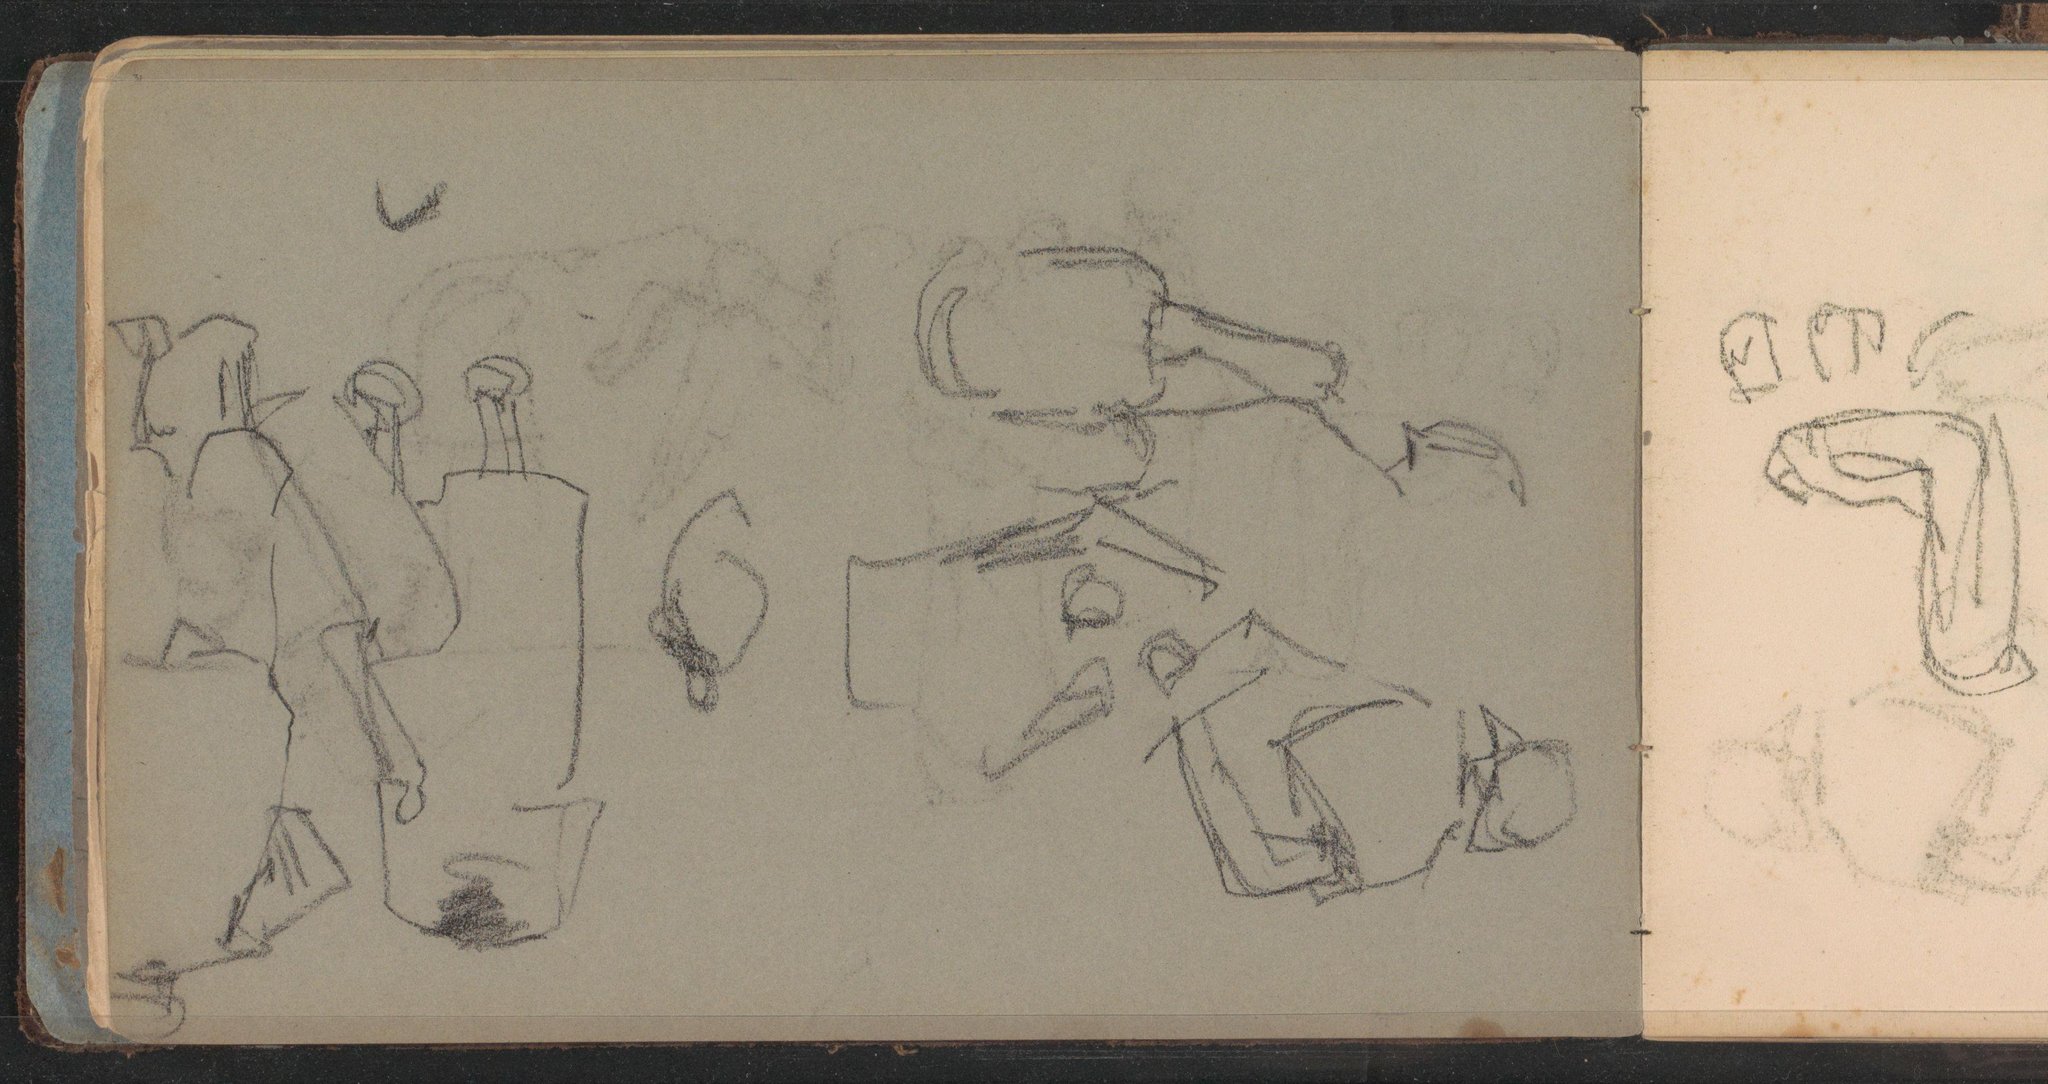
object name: sketchbook leaf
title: Figuurstudies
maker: george hendrik breitner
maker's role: draughtsman, painter, print maker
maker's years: 1857-1923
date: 1880-1882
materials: chalk, paper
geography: scheveningen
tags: adult woman, adult man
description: Pagina 31 uit een schetsboek met 37 bladen.